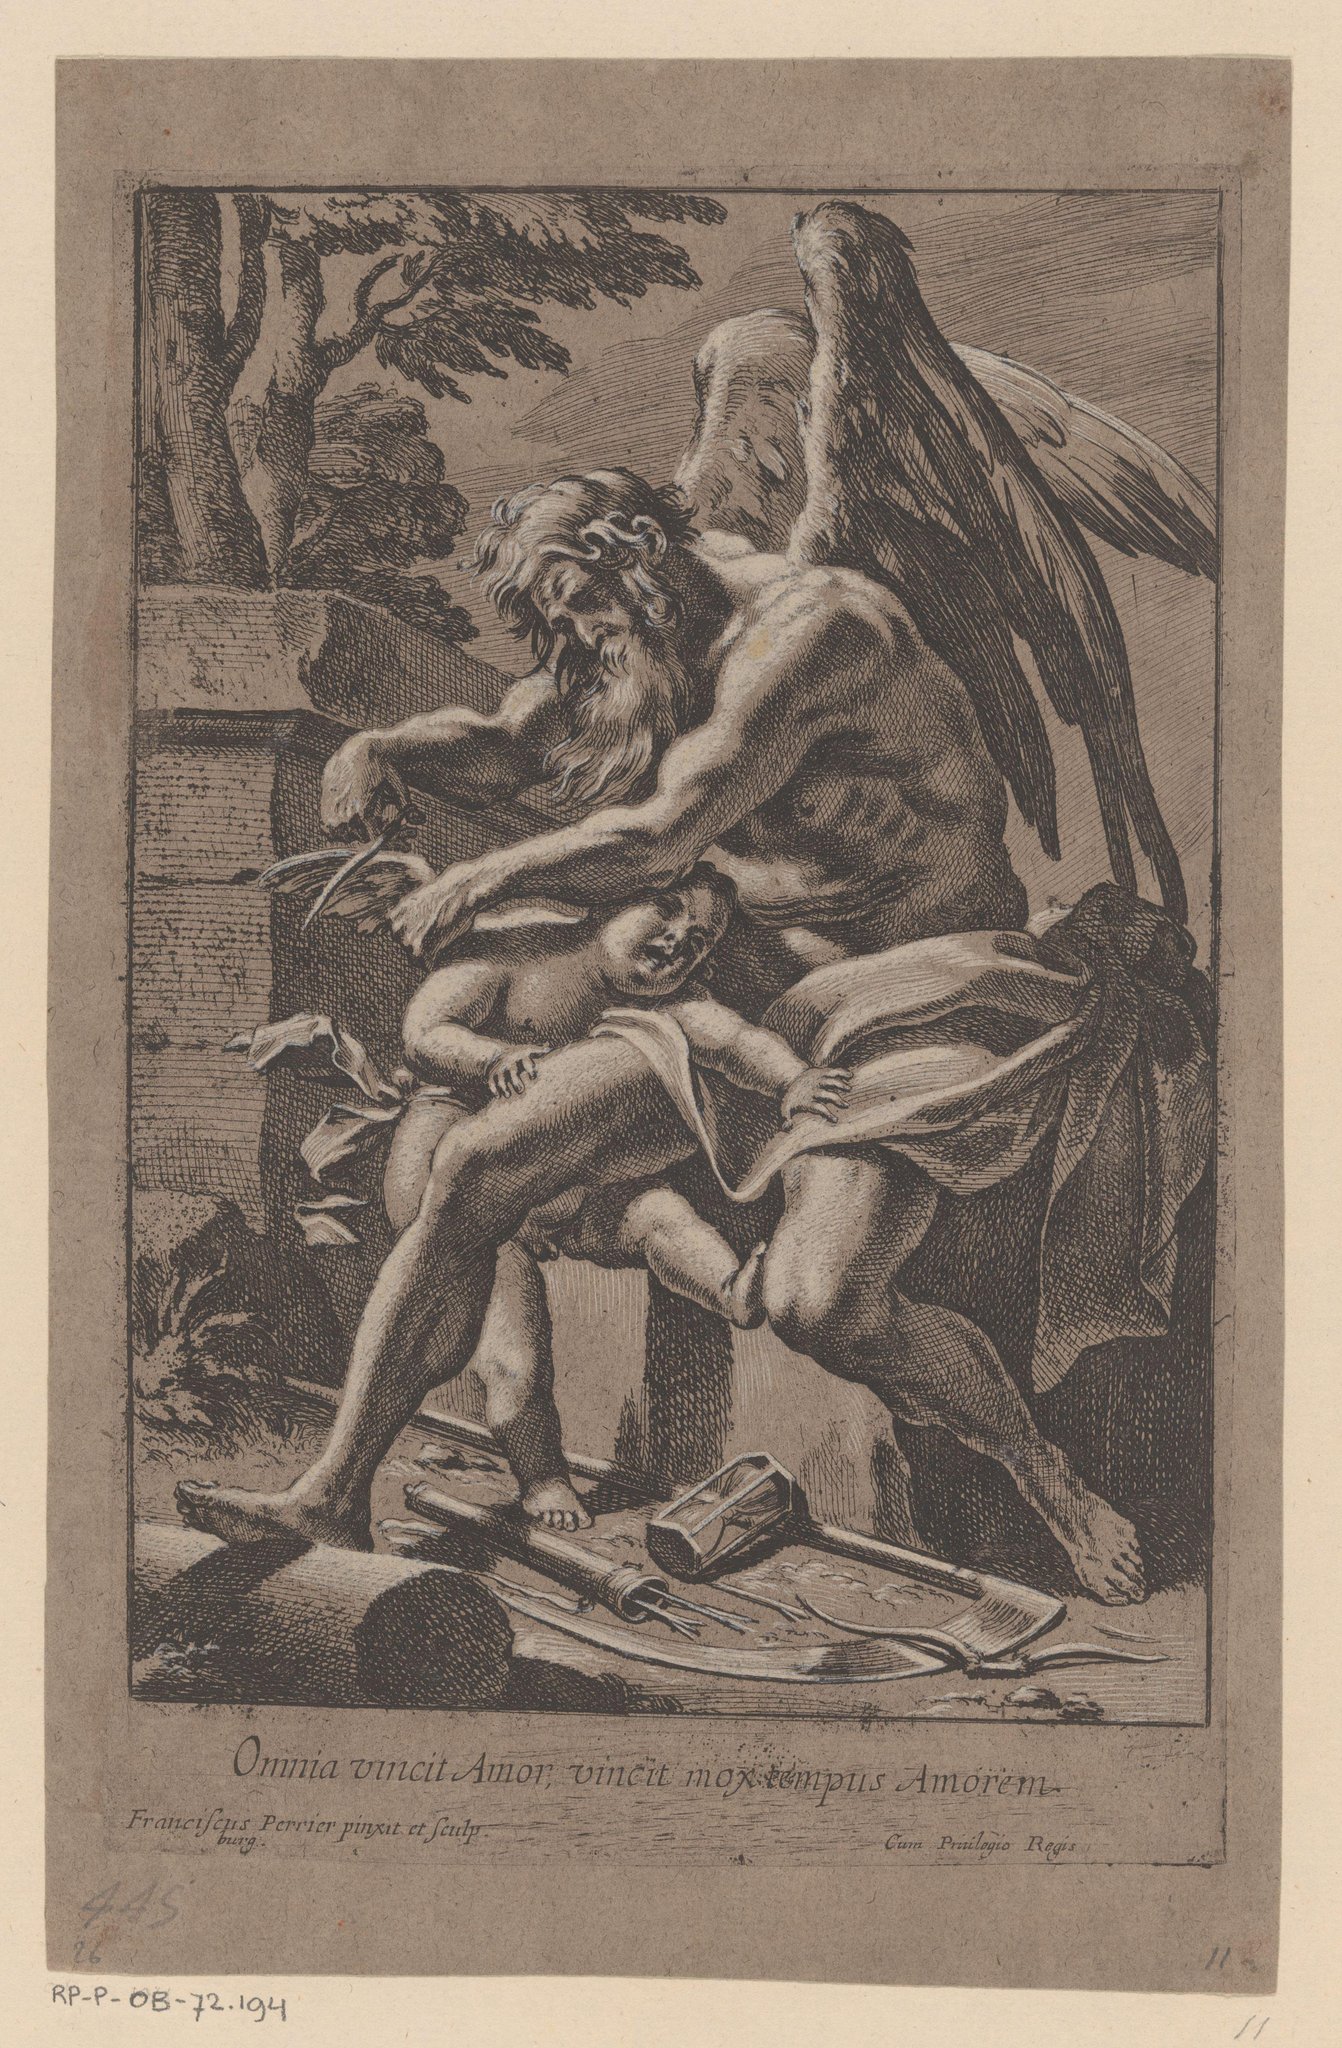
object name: print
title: Tijd knipt de vleugels van Amor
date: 1632-1633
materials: paper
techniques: etching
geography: france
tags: suffering, misfortune of cupid, father time, man with wings and scythe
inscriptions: collector's mark: Lugt 240